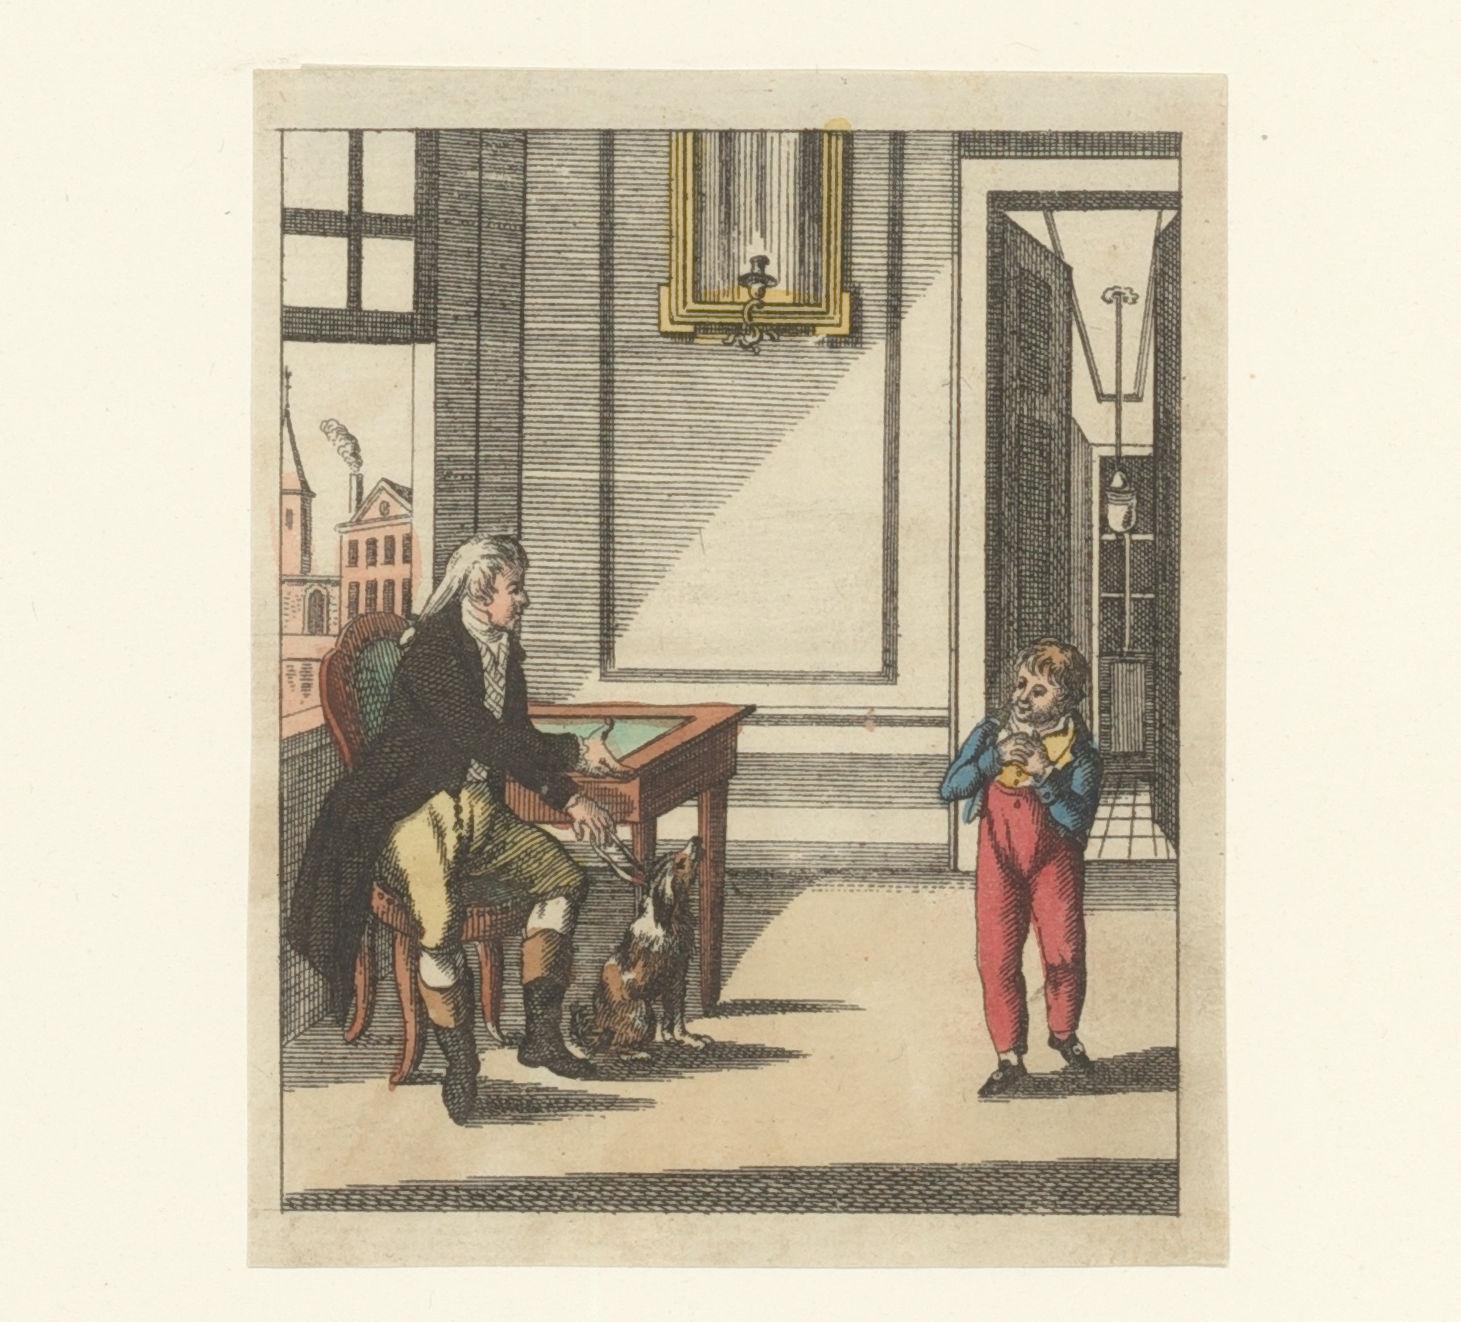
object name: print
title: Vader geeft een zoon een hond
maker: Anonymous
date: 1800-1899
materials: paper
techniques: etching, hand coloring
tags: father with son(s) (father-love), dog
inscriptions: stamp, collector's mark: Lugt 1641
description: Onderwerpsrubrieken binnen de Atlas Zeden en Gewoonten: Zeden en Gewoonten in Engeren Zin, Des menschen beging, midden en einde, Kinderleven – Kinderspel en Kinderprenten.